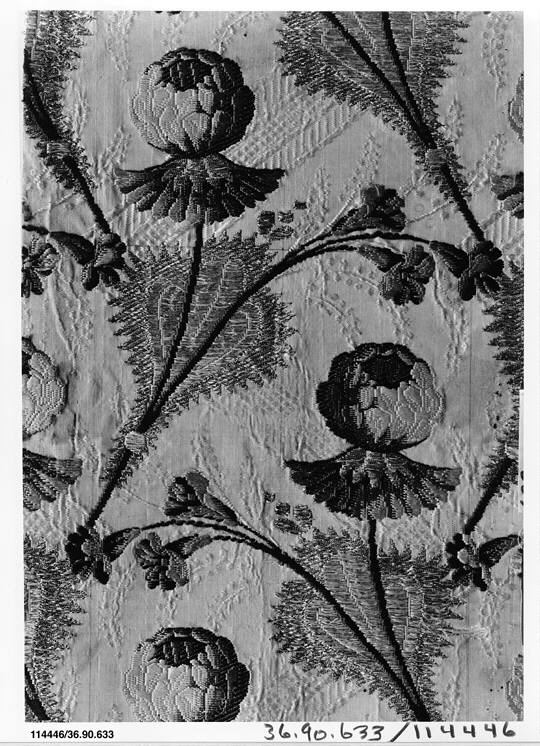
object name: piece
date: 1750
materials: metal thread, silk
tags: flowers